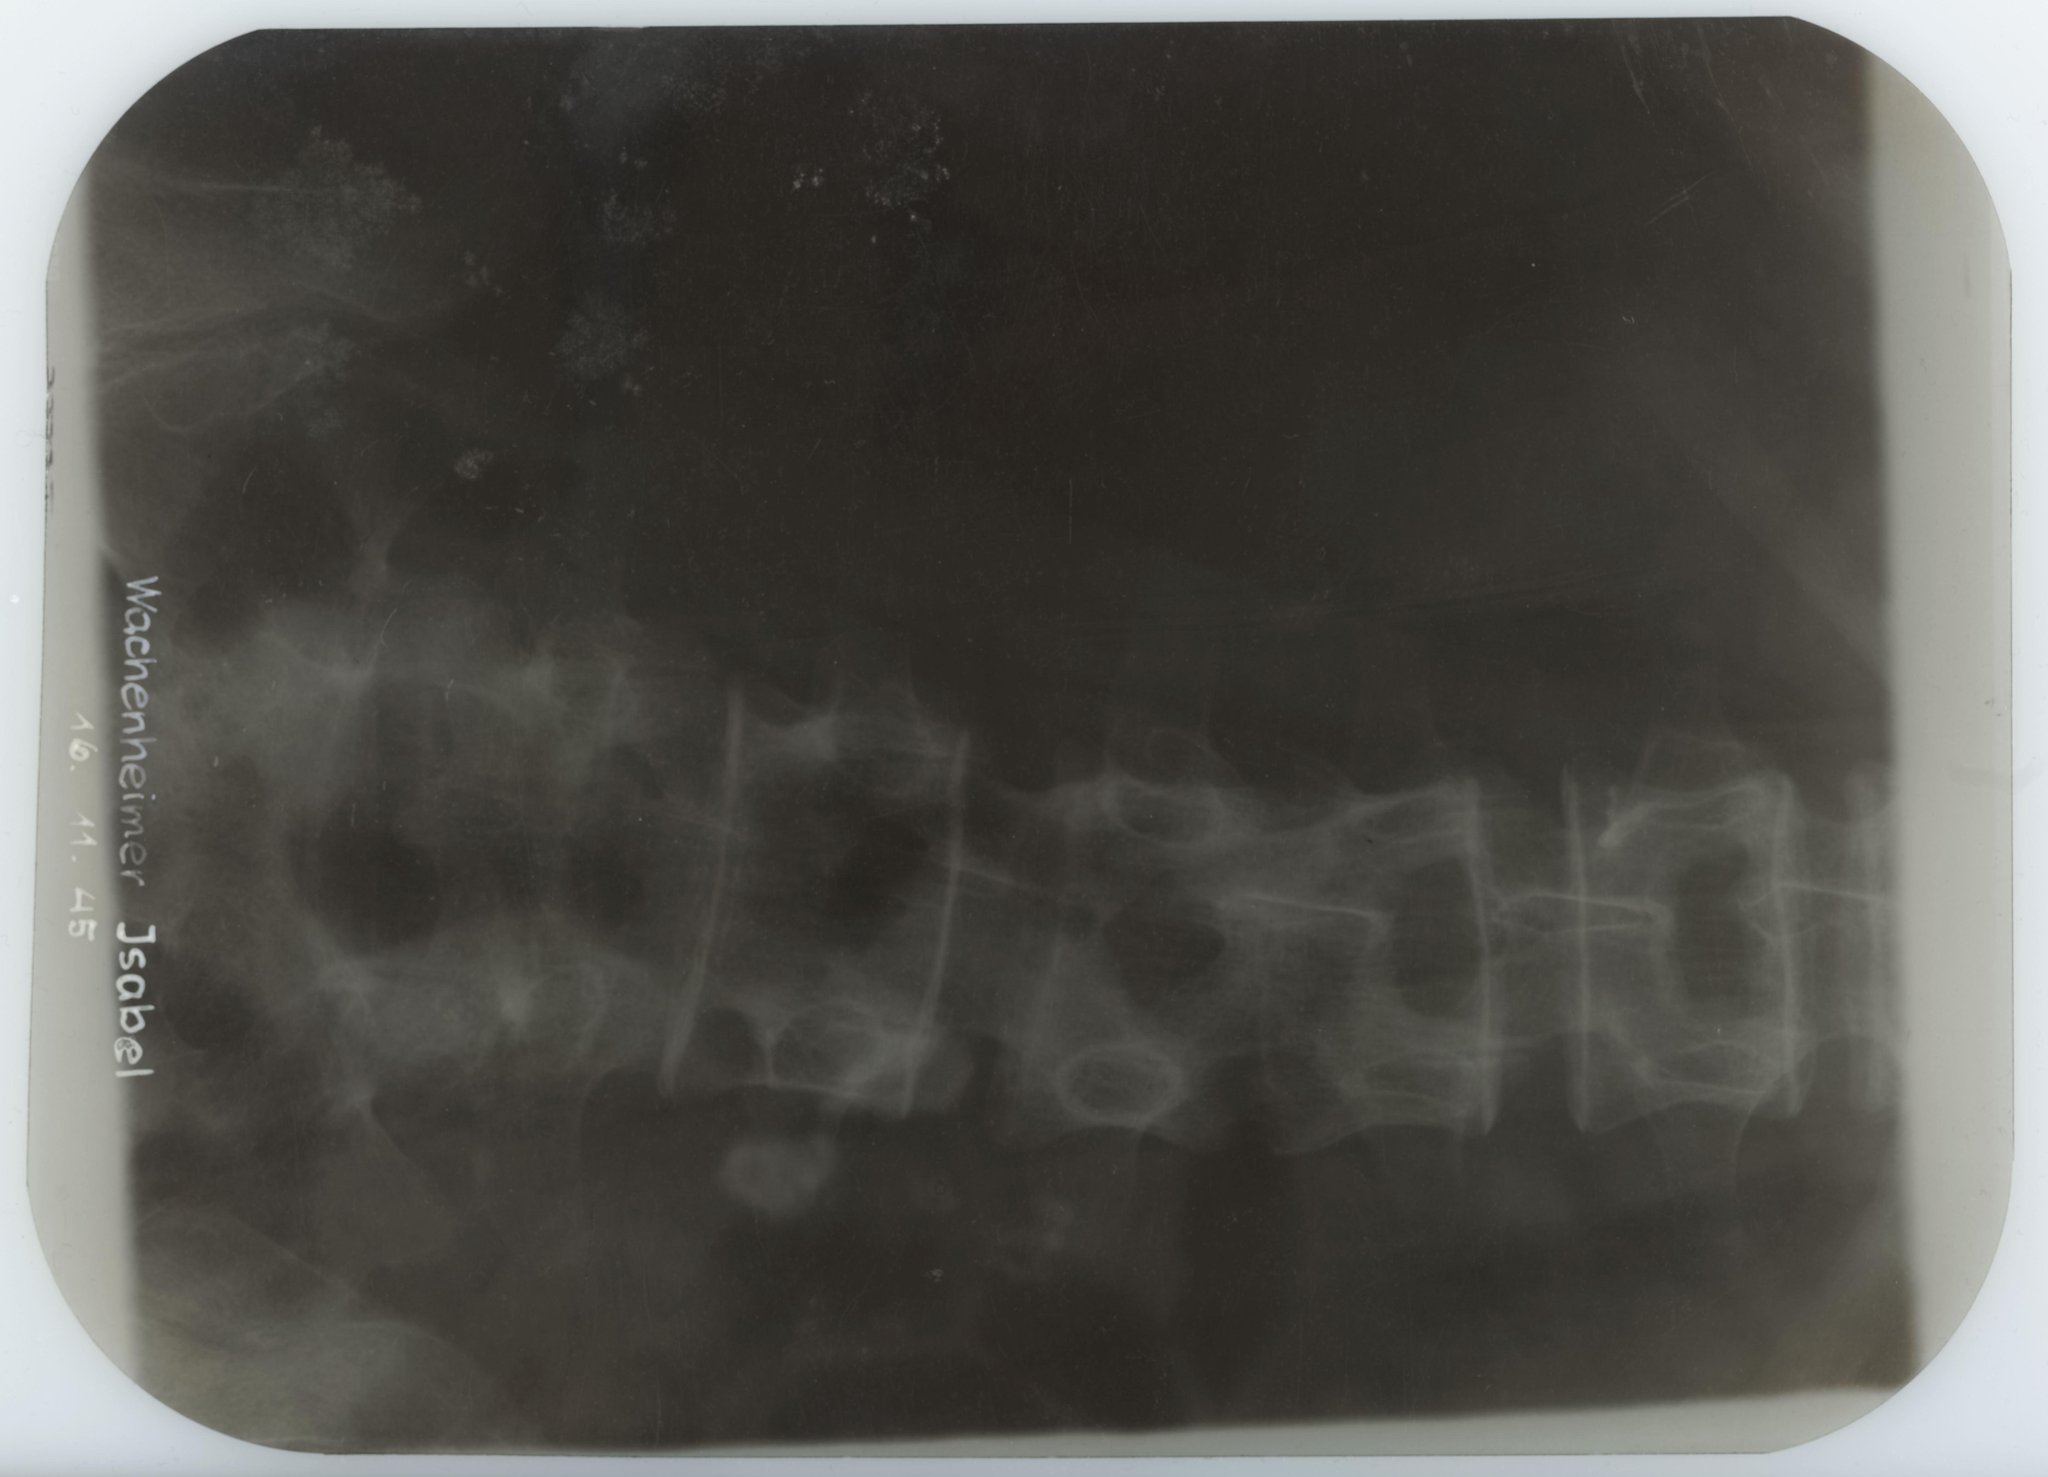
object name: photograph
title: Röntgenfoto van de ruggengraat van Isabel Wachenheimer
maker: Anonymous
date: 1935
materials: photographic support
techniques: gelatin silver print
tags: leiden, isabel wachenheimer-elon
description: Röntgenfoto van de ruggengraat van Isabel Wachenheimer